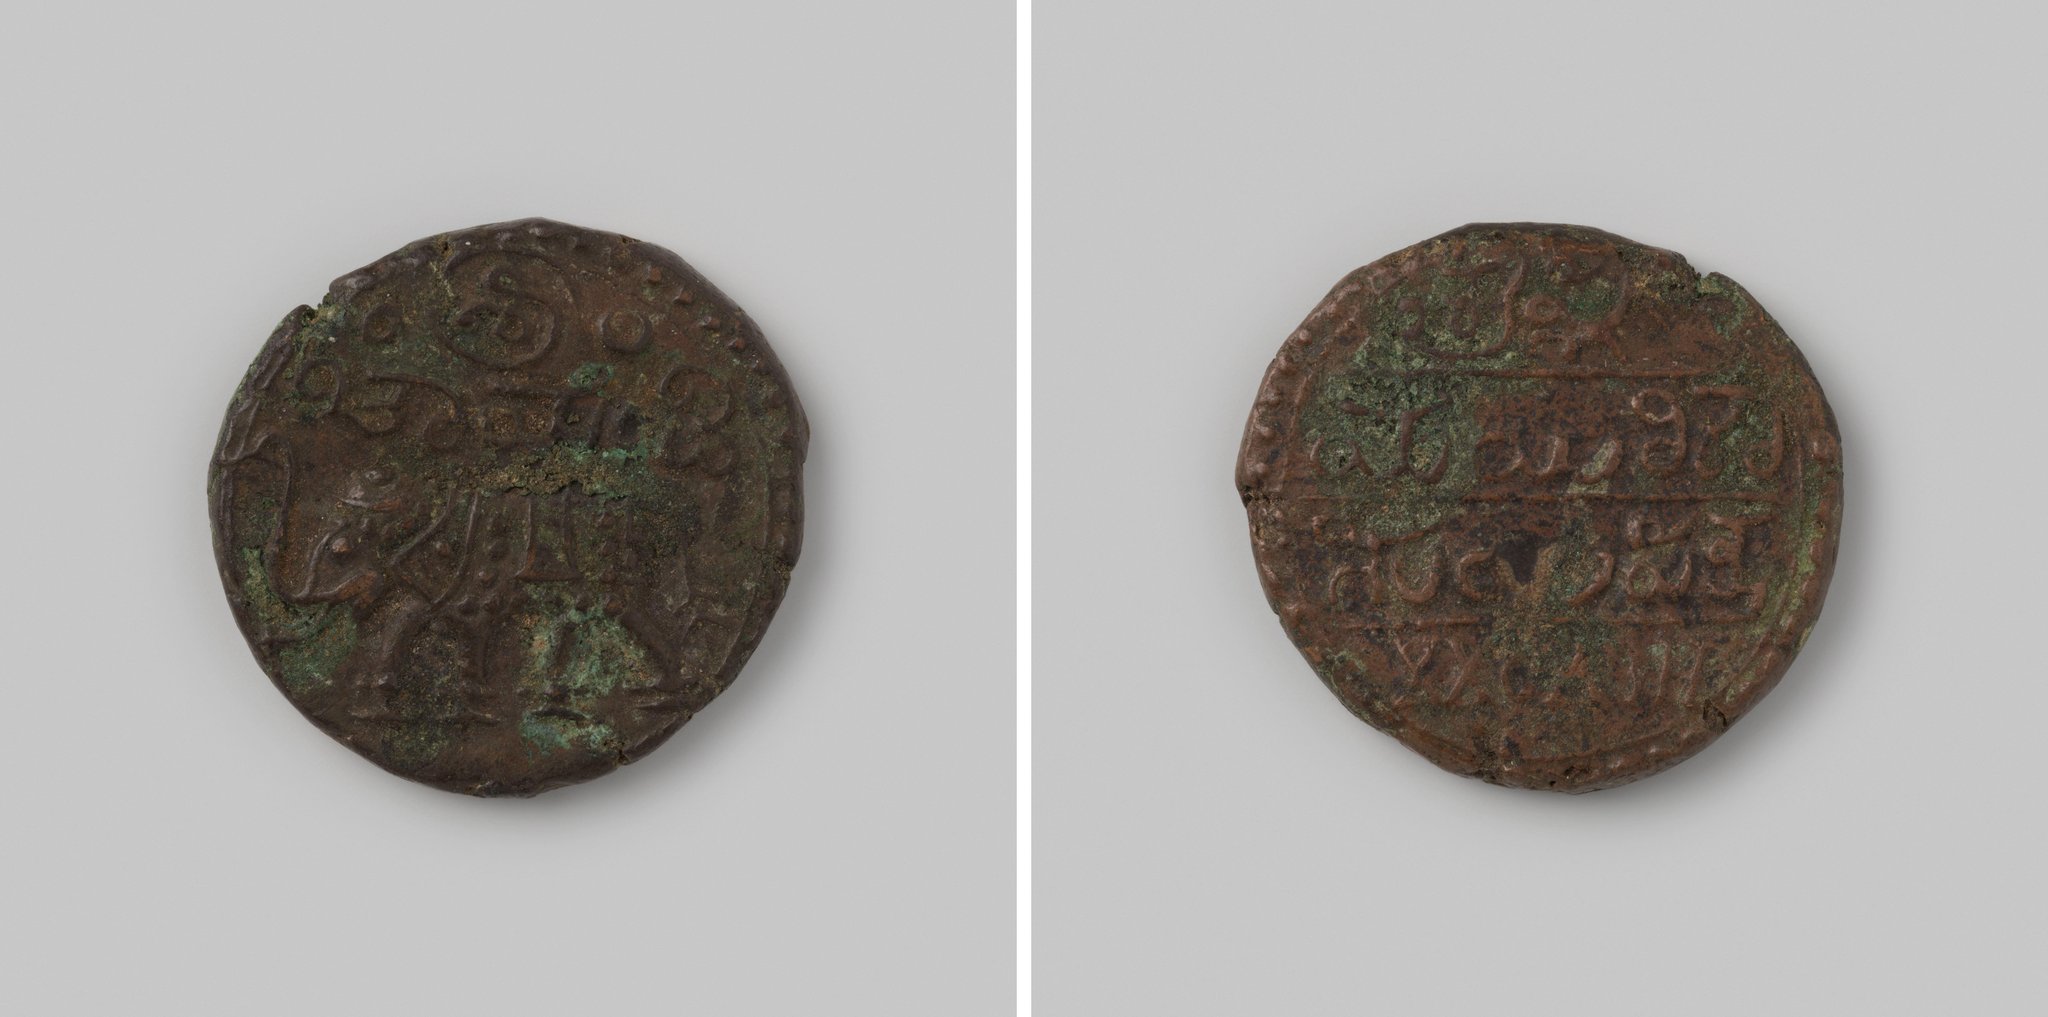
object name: coin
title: Mysore, India, paisa of 20 cash, Sri Krishna Raya Wodeyar,1799-1868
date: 1810-1833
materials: copper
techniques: striking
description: Koperen munt. Voorzijde: met kleden omhangen olifant, lopend naar links. Boven hem tussen zon en maan in Kanarees schrift de aanduiding Sri, waaronder een regelig opschrift. Keerzijde: in Kanarees schrift drieregelig opschrift. Daaronder waarde-aanduiding: XX Cash..